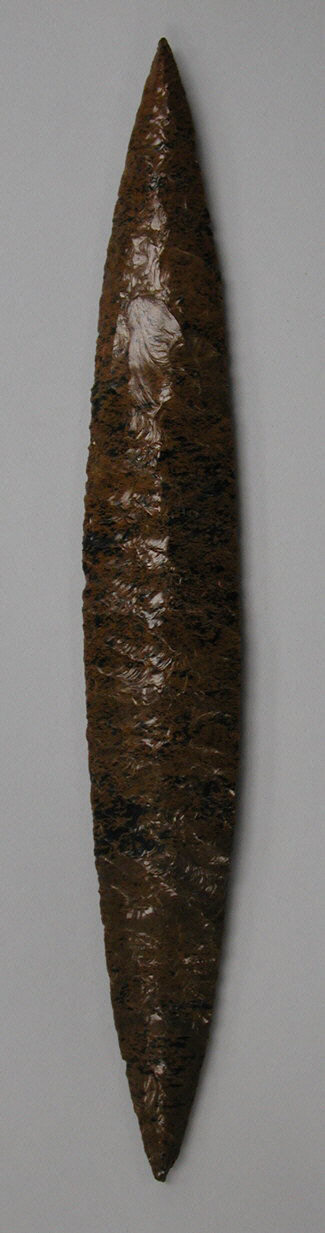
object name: knife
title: Flint Blade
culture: mexican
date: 1501-1600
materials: stone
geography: mexico